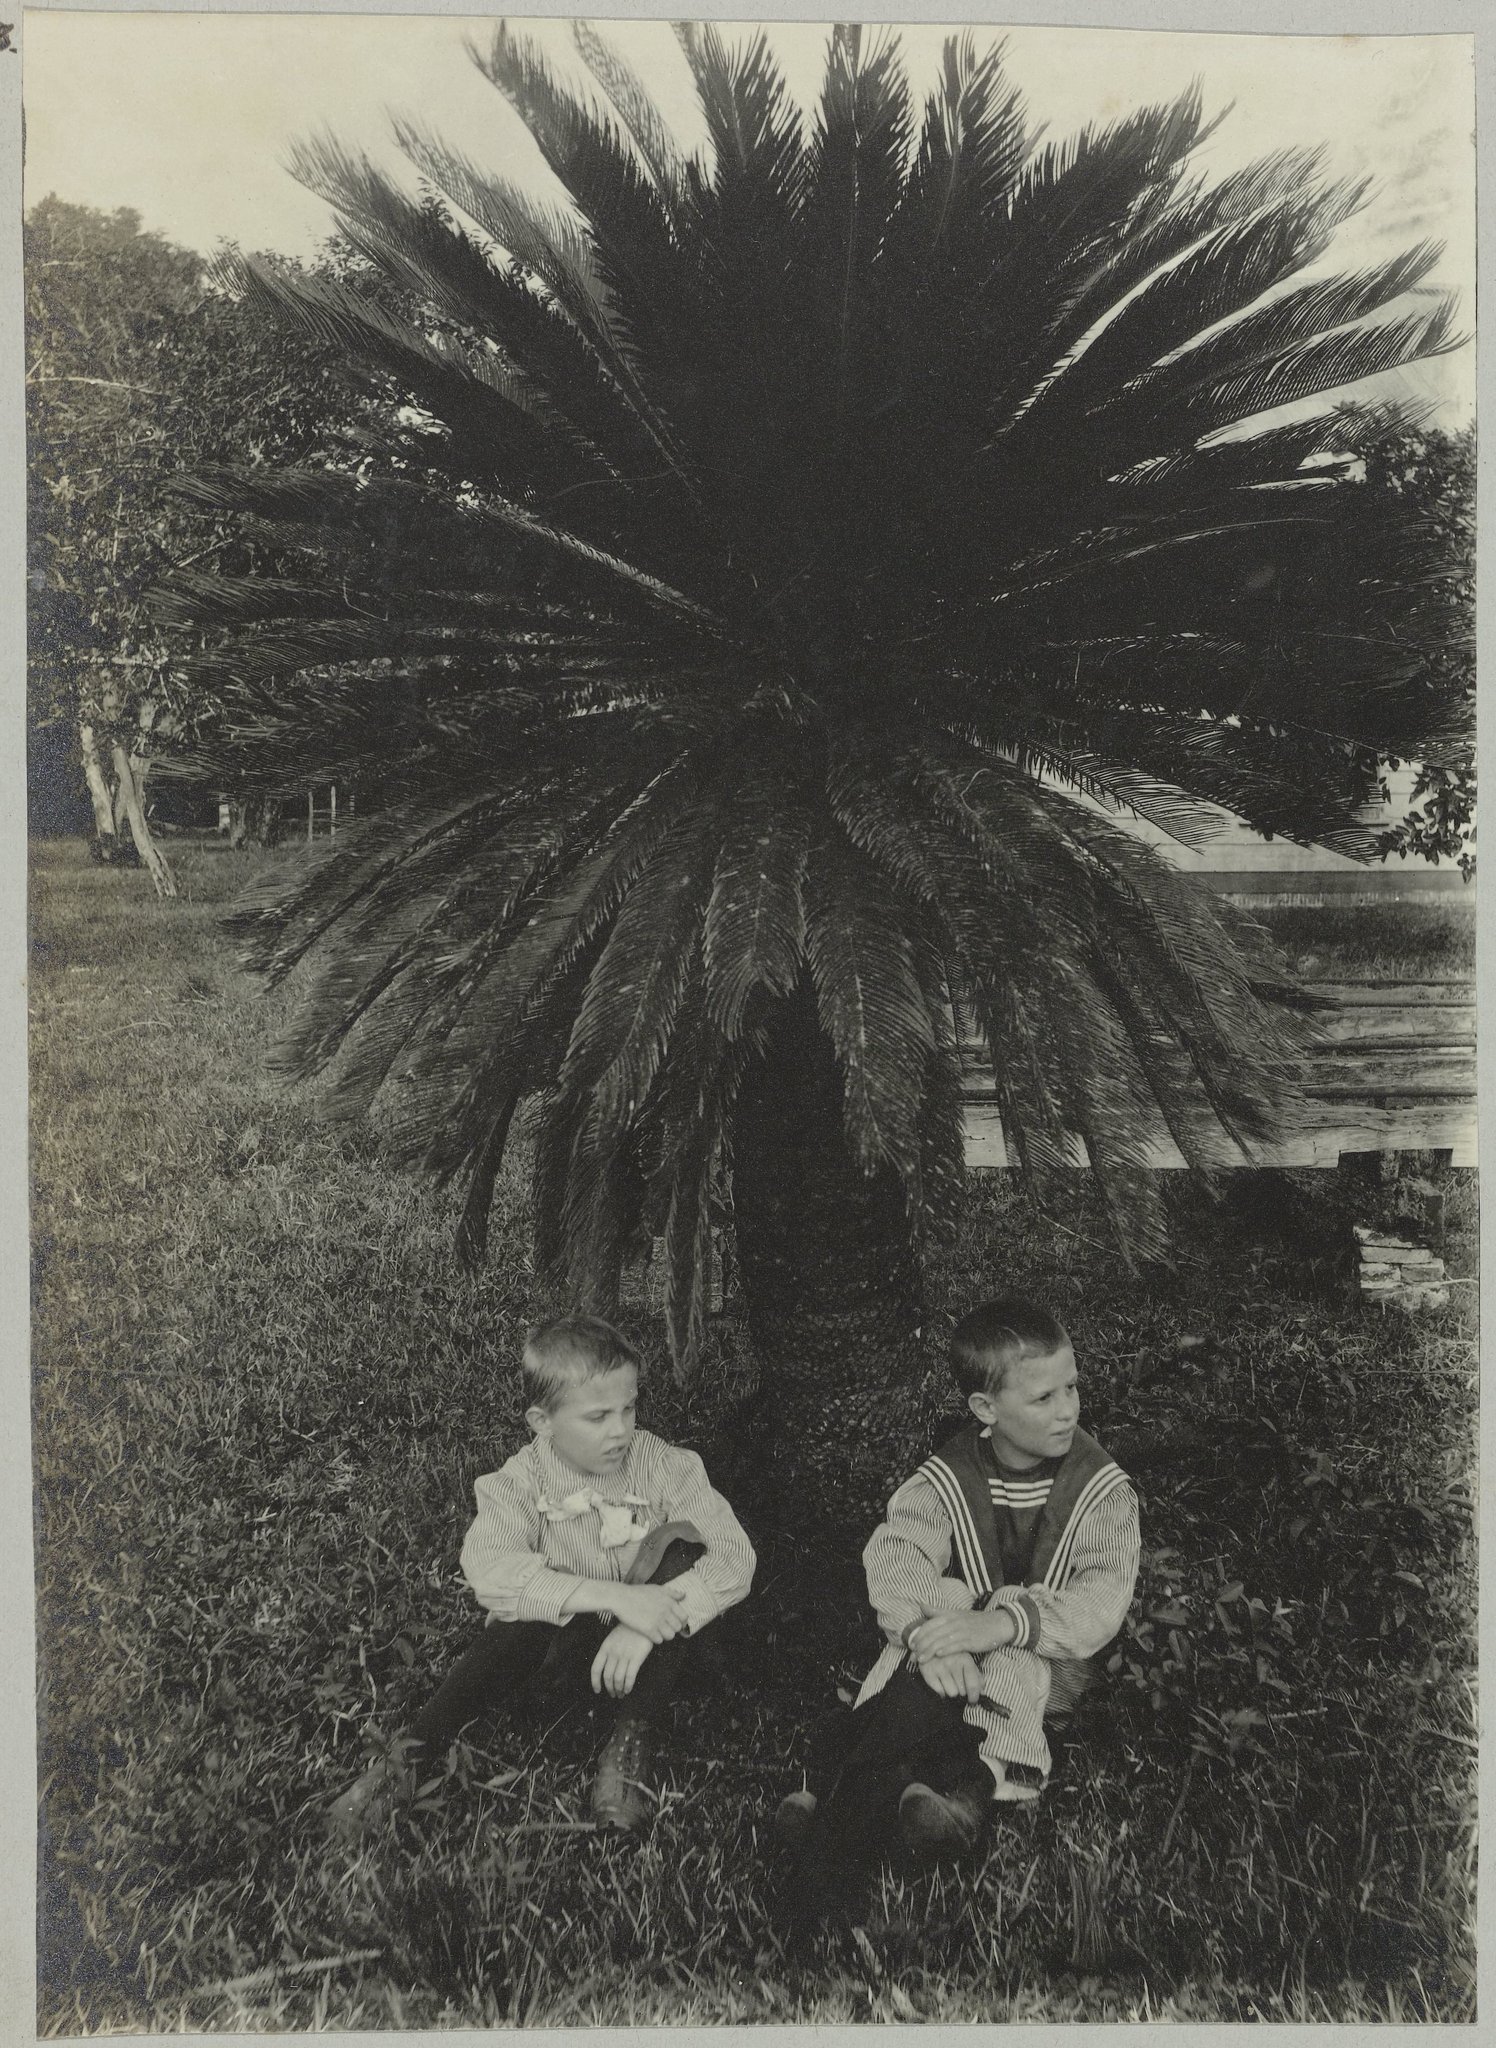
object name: photograph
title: Anton en Piet onder sagopalm. (Tourtonne)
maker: hendrik doijer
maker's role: engineer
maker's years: 1863-1925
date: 1903-1910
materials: photographic support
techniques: gelatin silver print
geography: suriname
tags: suriname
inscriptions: inscription: ‘A3 / Anton en Piet onder sagopalm. (Tourtonne). (zie F9)’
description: Twee Hollandse jongens genaamd Anton en Piet zittend onder een sagopalm op de plantage Tourtonne. Onderdeel van het fotoalbum Souvenir de Voyage (deel 1), over het leven van de familie Doijer in en rond de plantage Ma Retraite in Suriname in de jaren 1903-1910.